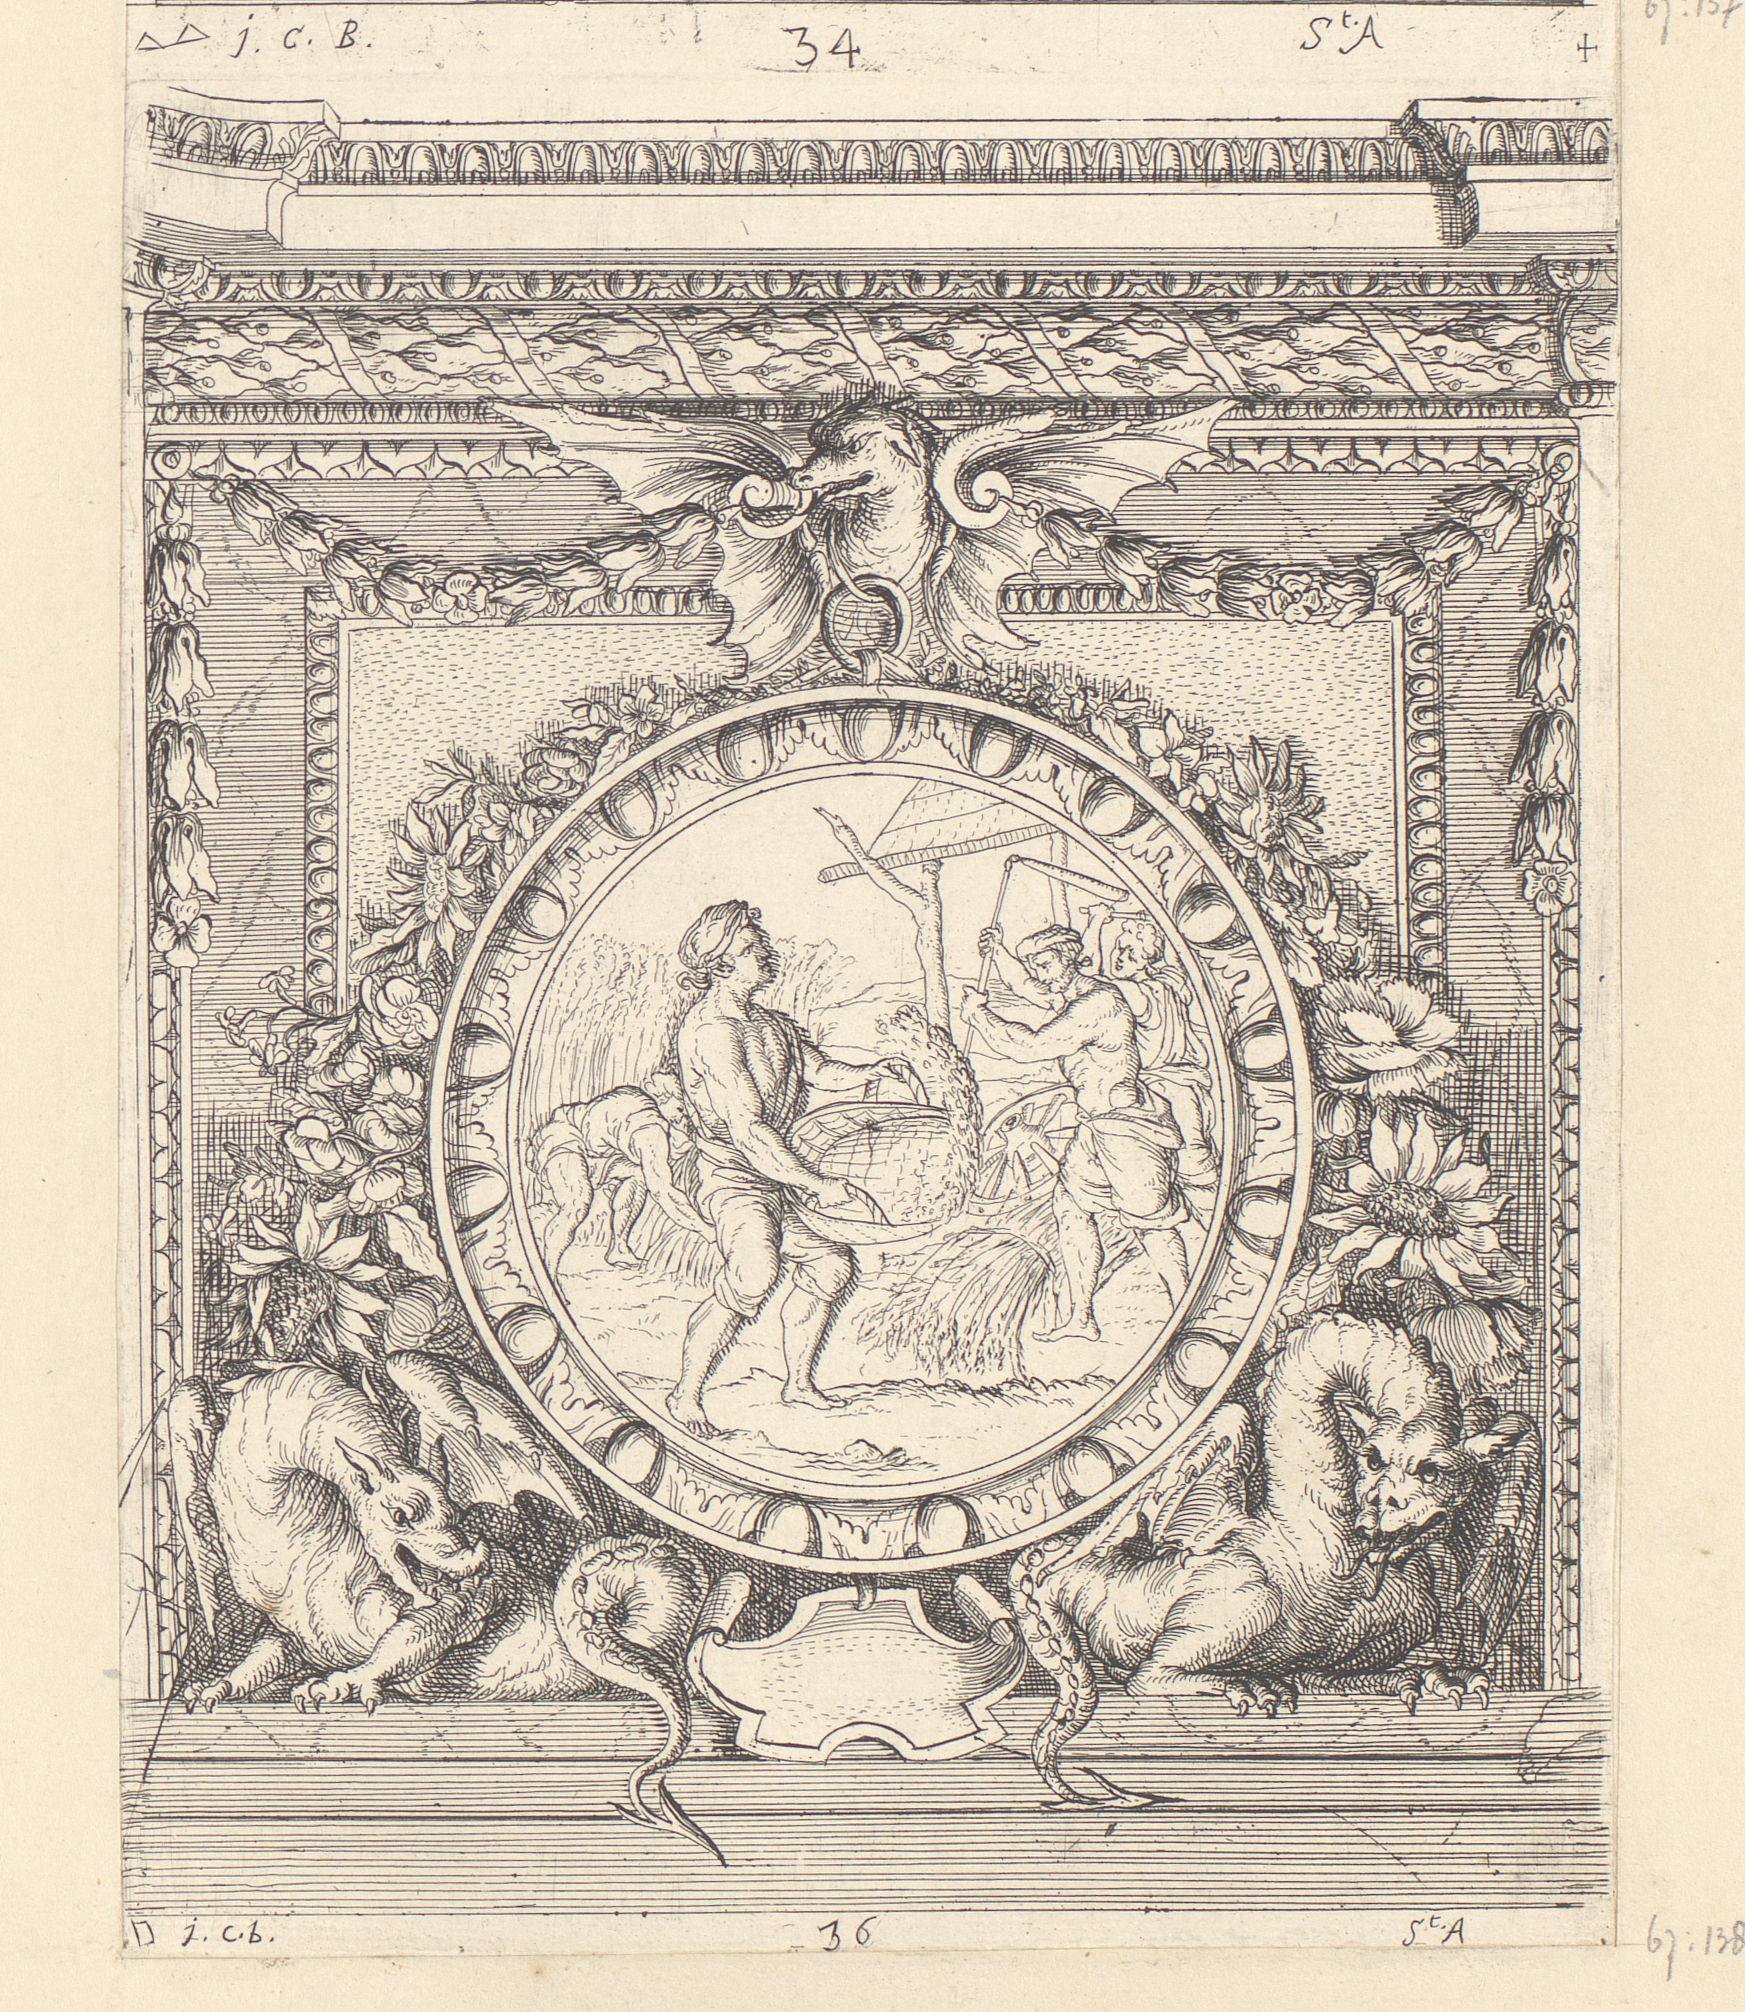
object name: print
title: Kleine galerie van het Louvre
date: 1695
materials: paper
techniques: etching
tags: ornaments ~ art, fabulous animals ~ lizards, july and its 'labours', agricultural implements: flail, cereal, grain, corn (grass with grains, grown for food, e.g.: wheat, rice, rye, oats, maize, buckwheat, millet)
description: Een draak aan weerszijden van een medaillon met daarop graanoogst en dorsen. Deze prent maakt deel uit van een album.